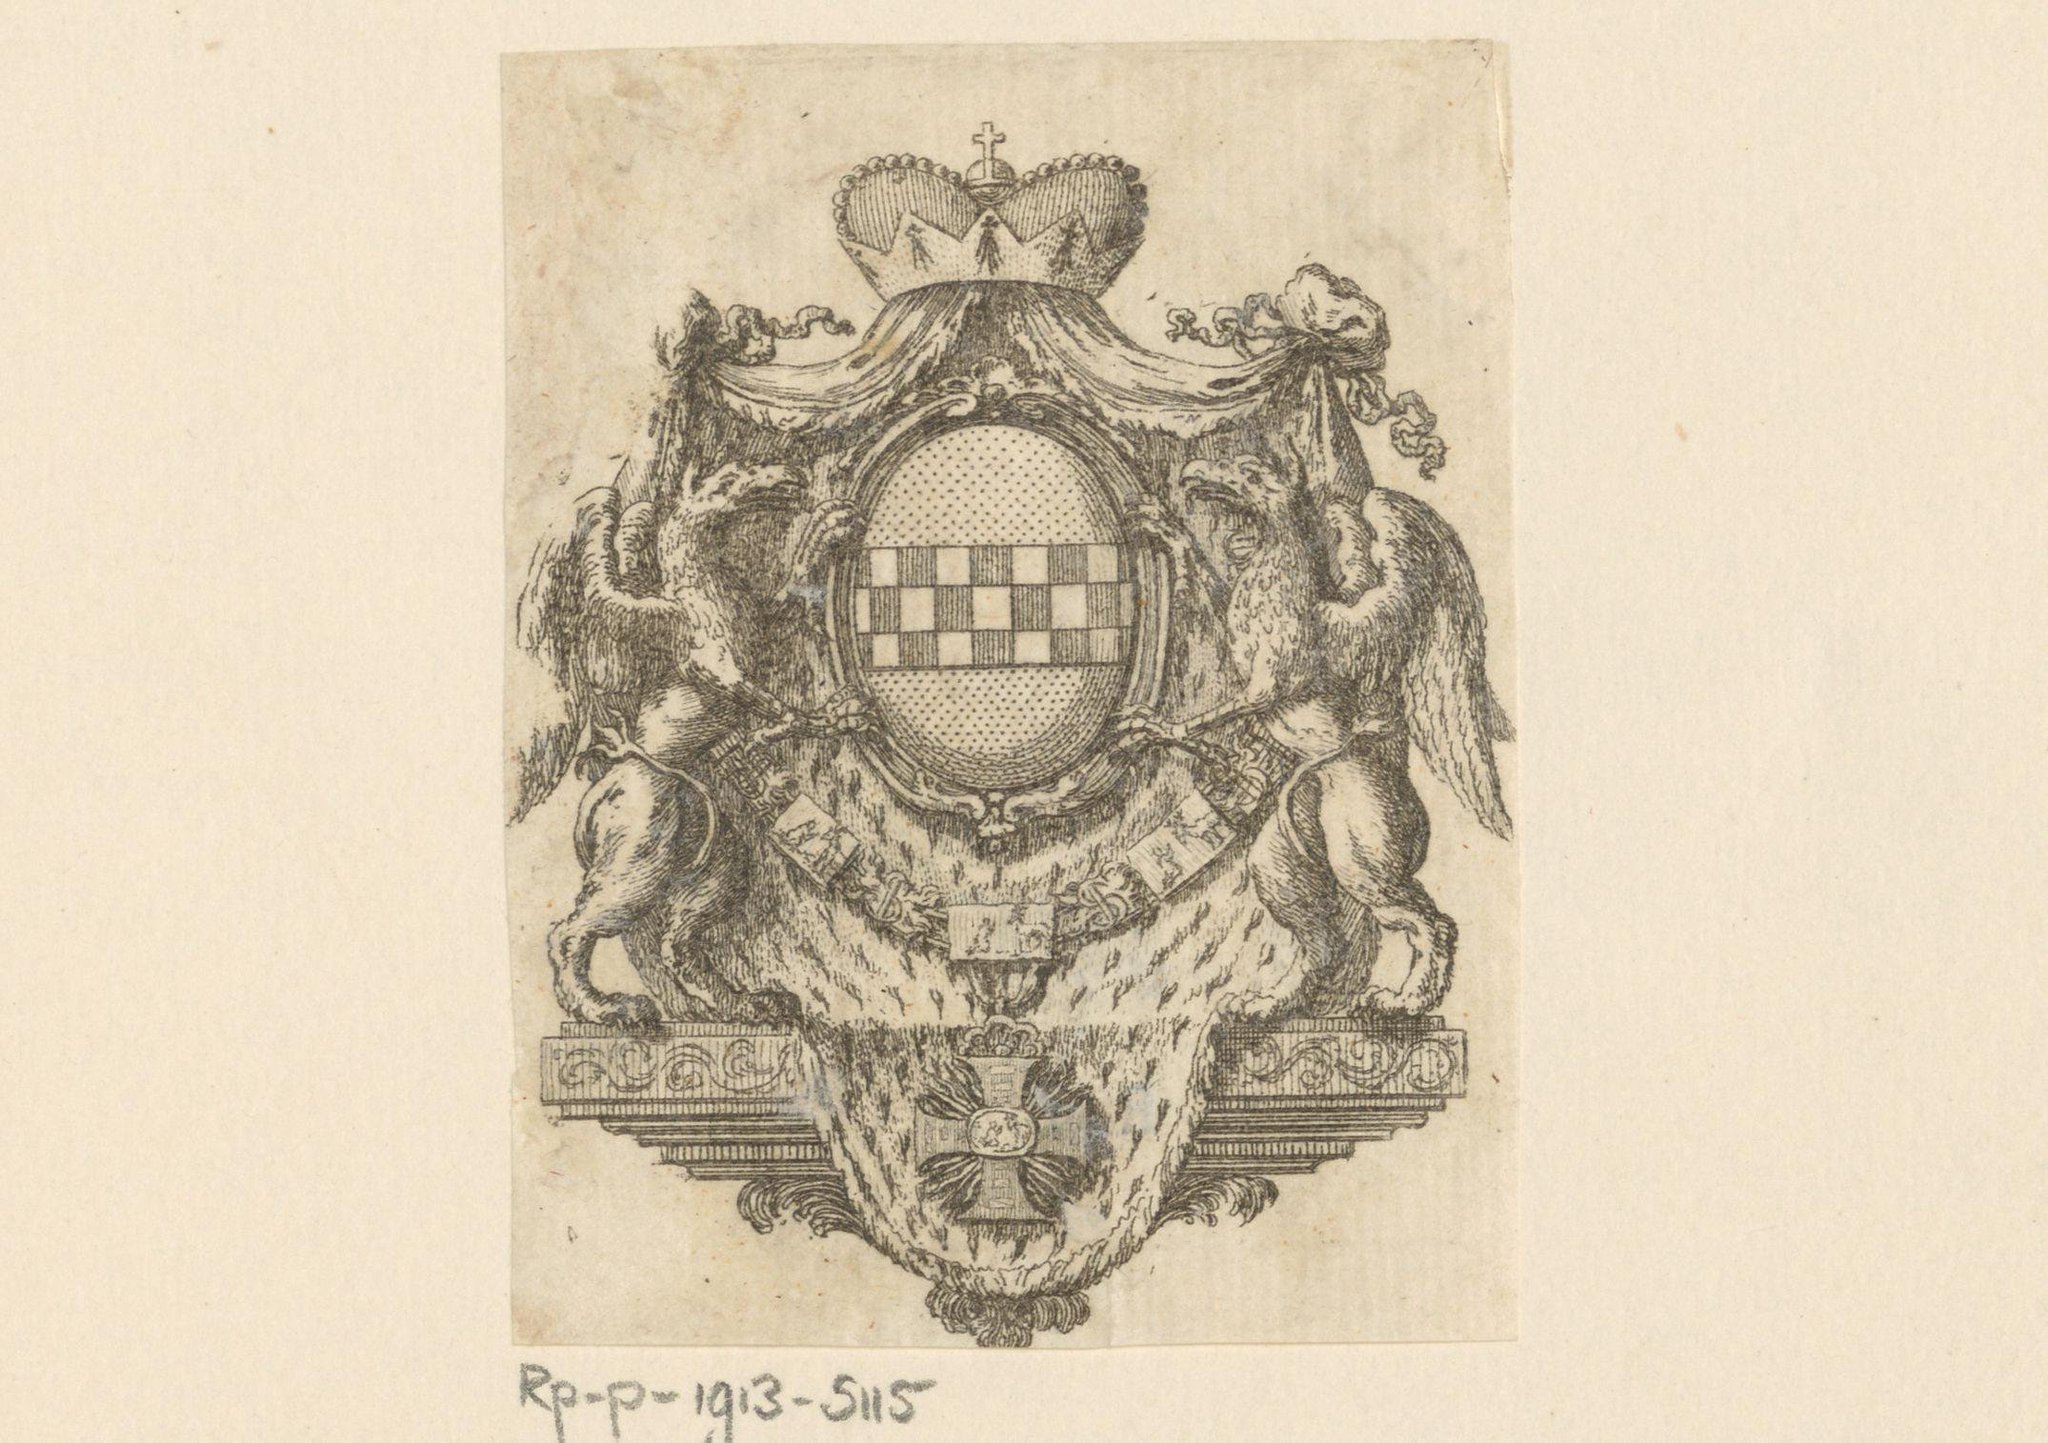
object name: bookplate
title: Ex libris van onbekend, mogelijk De la Marek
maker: Anonymous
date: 1750-1849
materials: paper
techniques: etching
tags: armorial bearing, heraldry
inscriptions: collector's mark: Lugt 2233, collector's mark: Lugt 2760